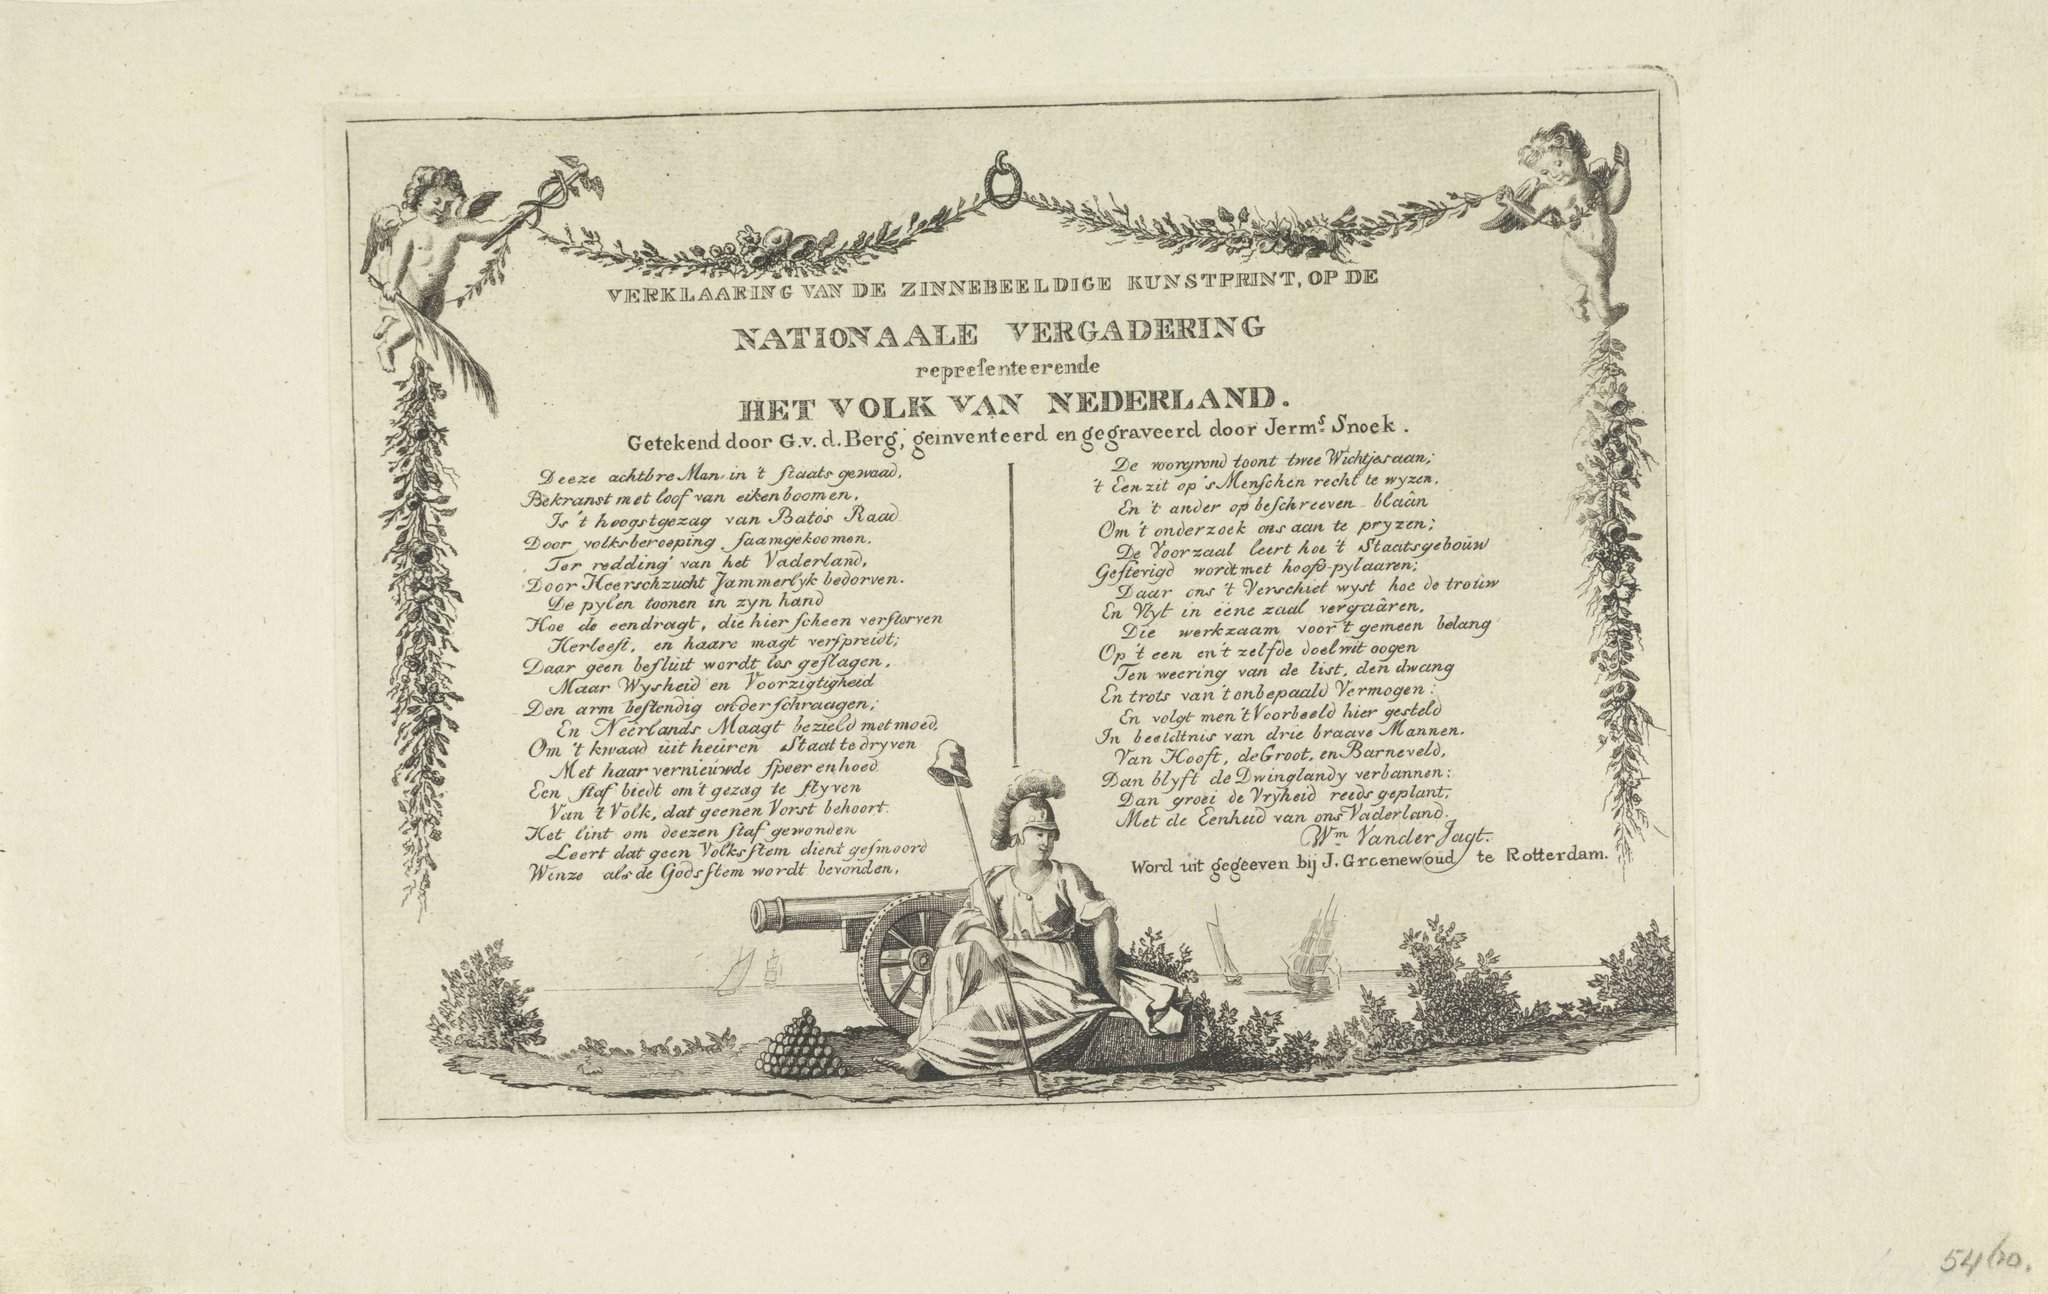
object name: print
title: Verklaaring van de Zinnebeeldige Kunstprint, op de Nationaale Vergadering representeerende het Volk van Nederland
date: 1797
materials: paper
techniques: engraving, etching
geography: rotterdam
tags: personifications of countries, nations, states, districts, etc., netherlands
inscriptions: collector's mark: Lugt 2228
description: Verklaring van de voorstelling van de prent met de allegorie op de Eerste Nationale Vergadering, geopend in Den Haag op 1 maart 1796. Verklaring in versvorm in twee kolommen. Onderaan de Nederlandse maagd, boven en aan weerszijden bloemenguirlandes.